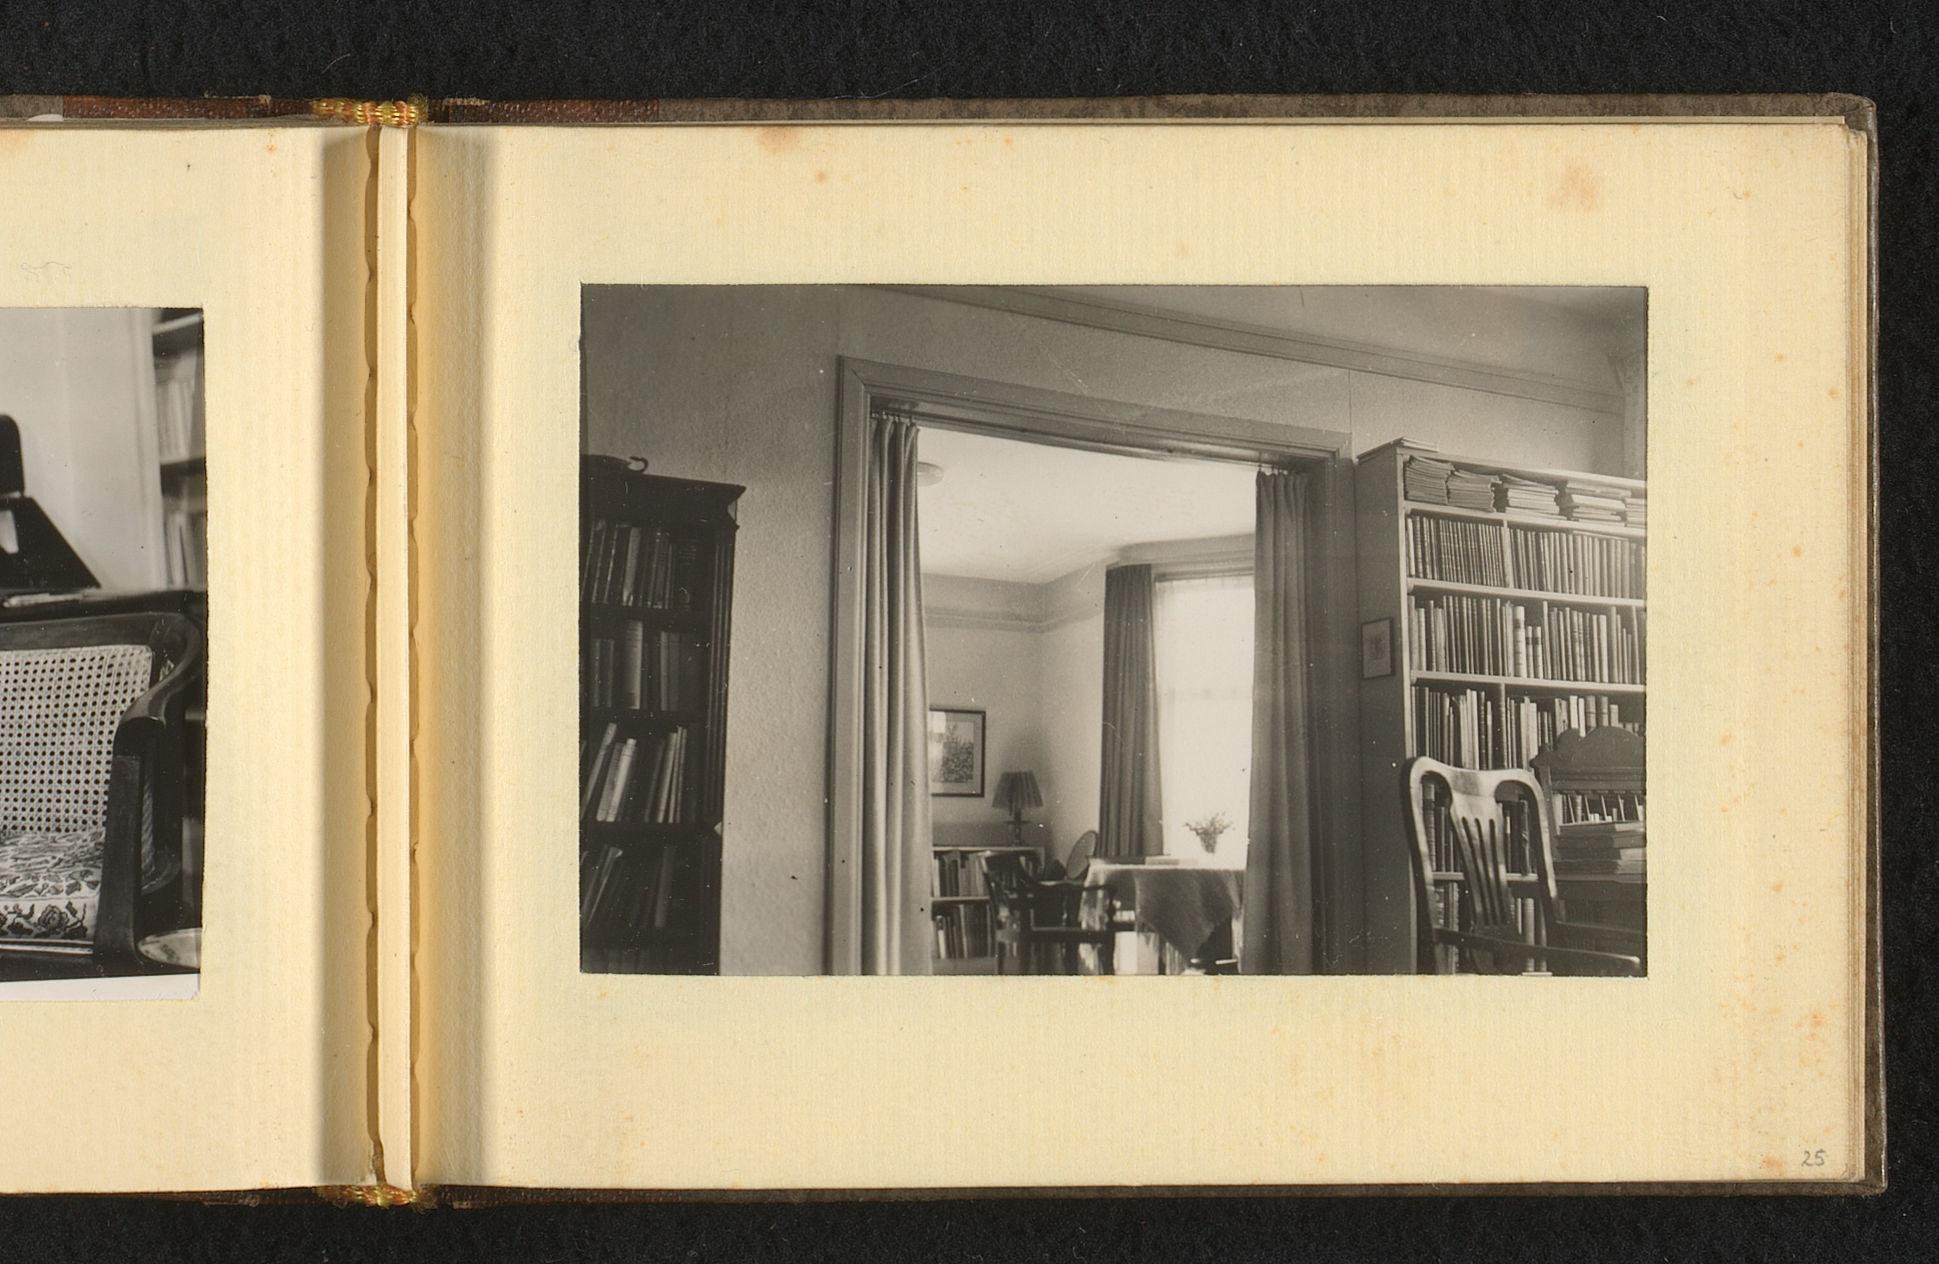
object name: album leaf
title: Interieur met boekenkasten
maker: norbert van den berg (1901-1972)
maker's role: amateurfotograaf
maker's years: 1901-1972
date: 1935-1950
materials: paper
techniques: gelatin silver print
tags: bookcase, with doors, interior of the house